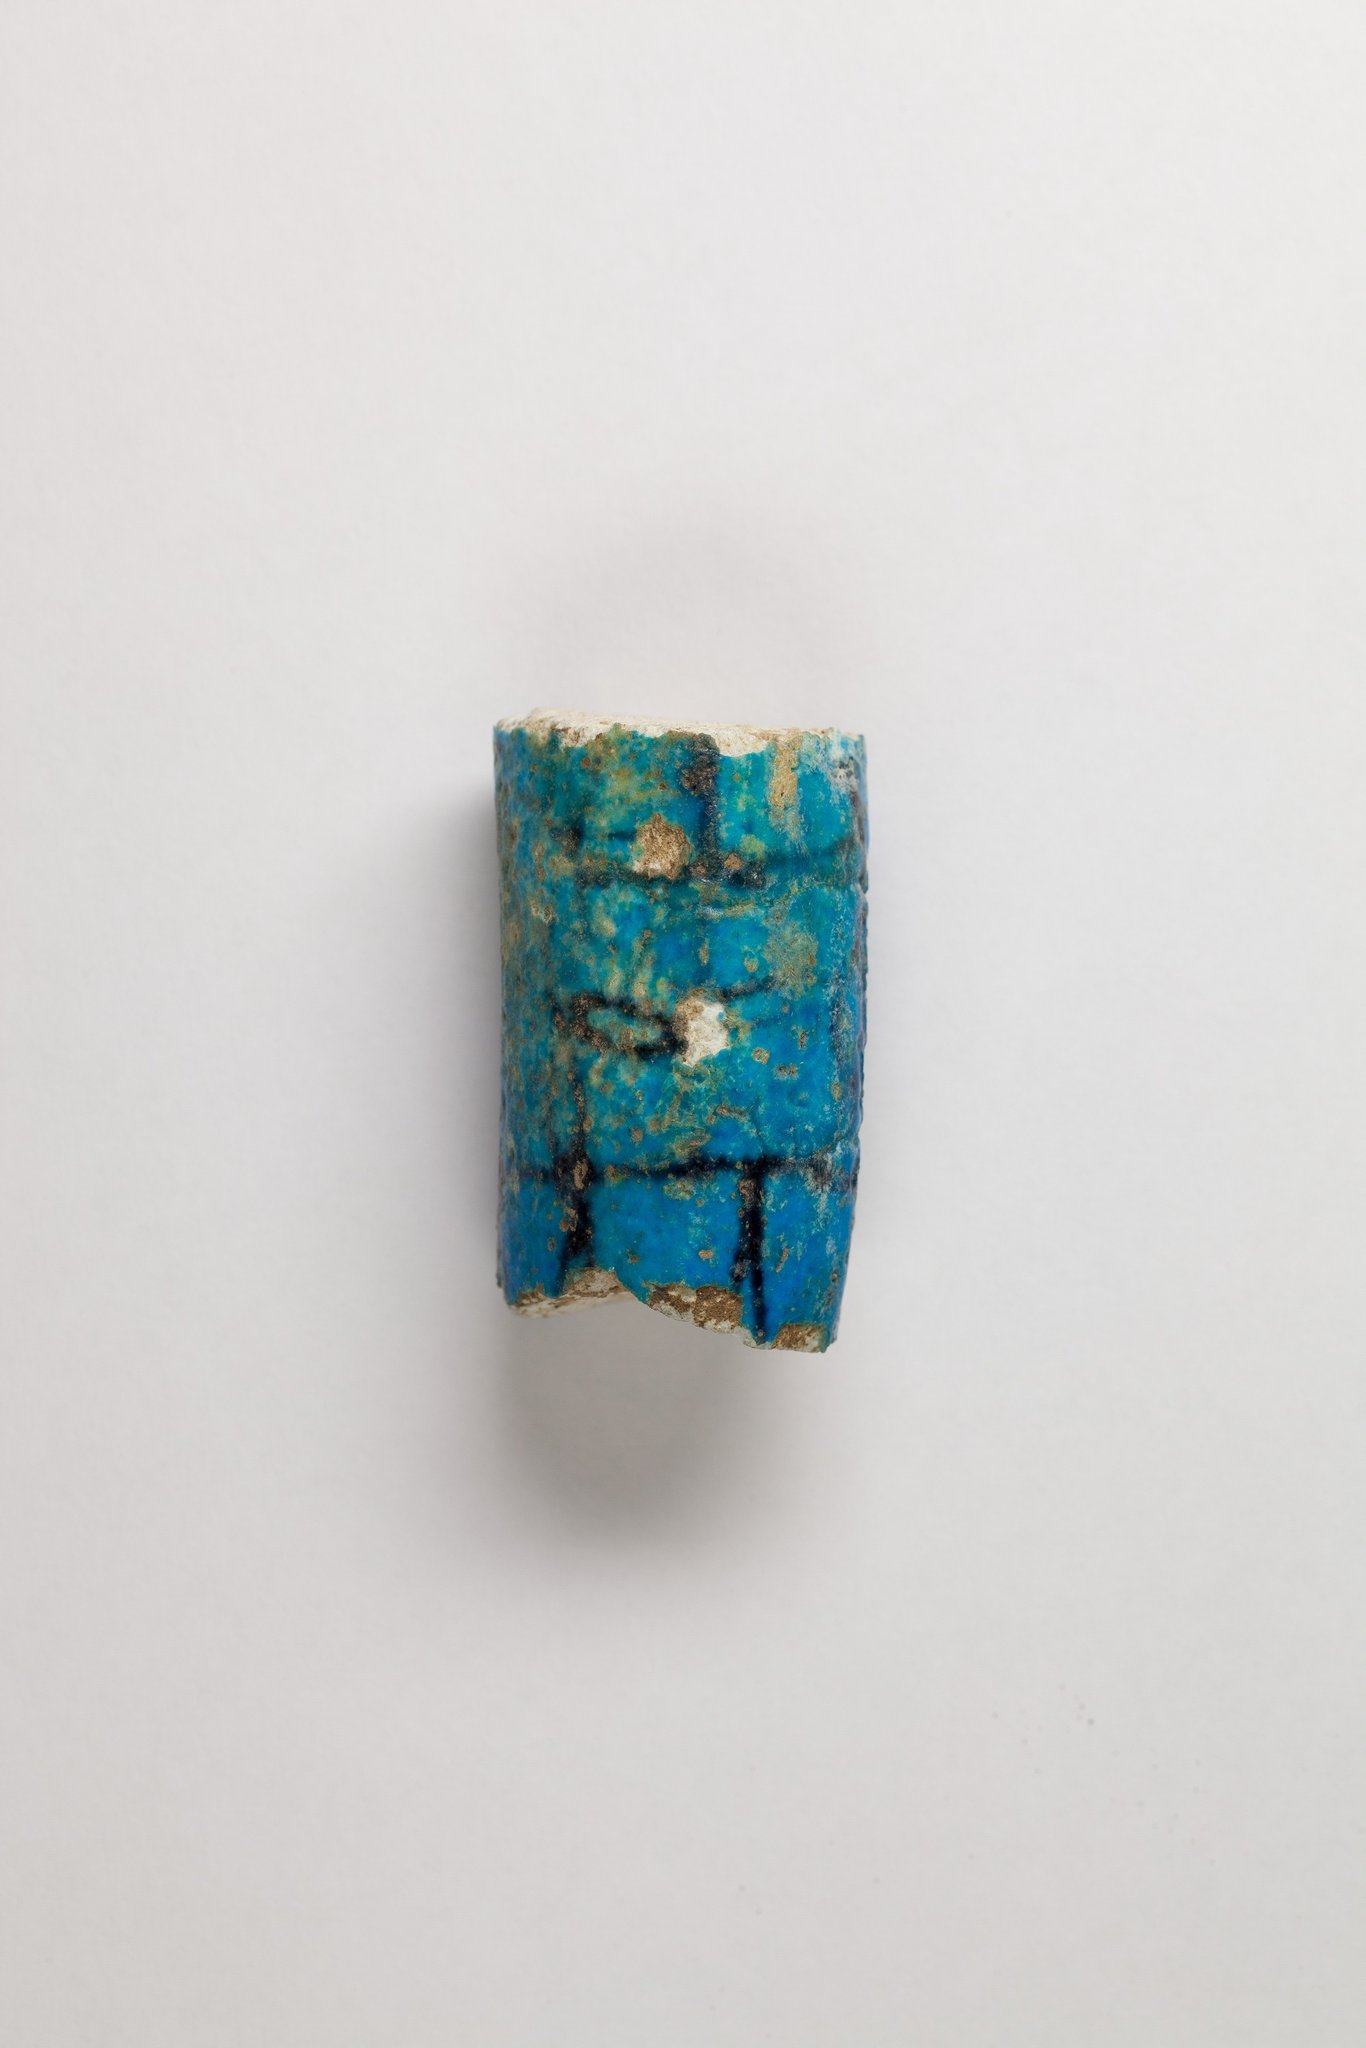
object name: bracelet fragment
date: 1981-1640 BCE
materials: faience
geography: egypt